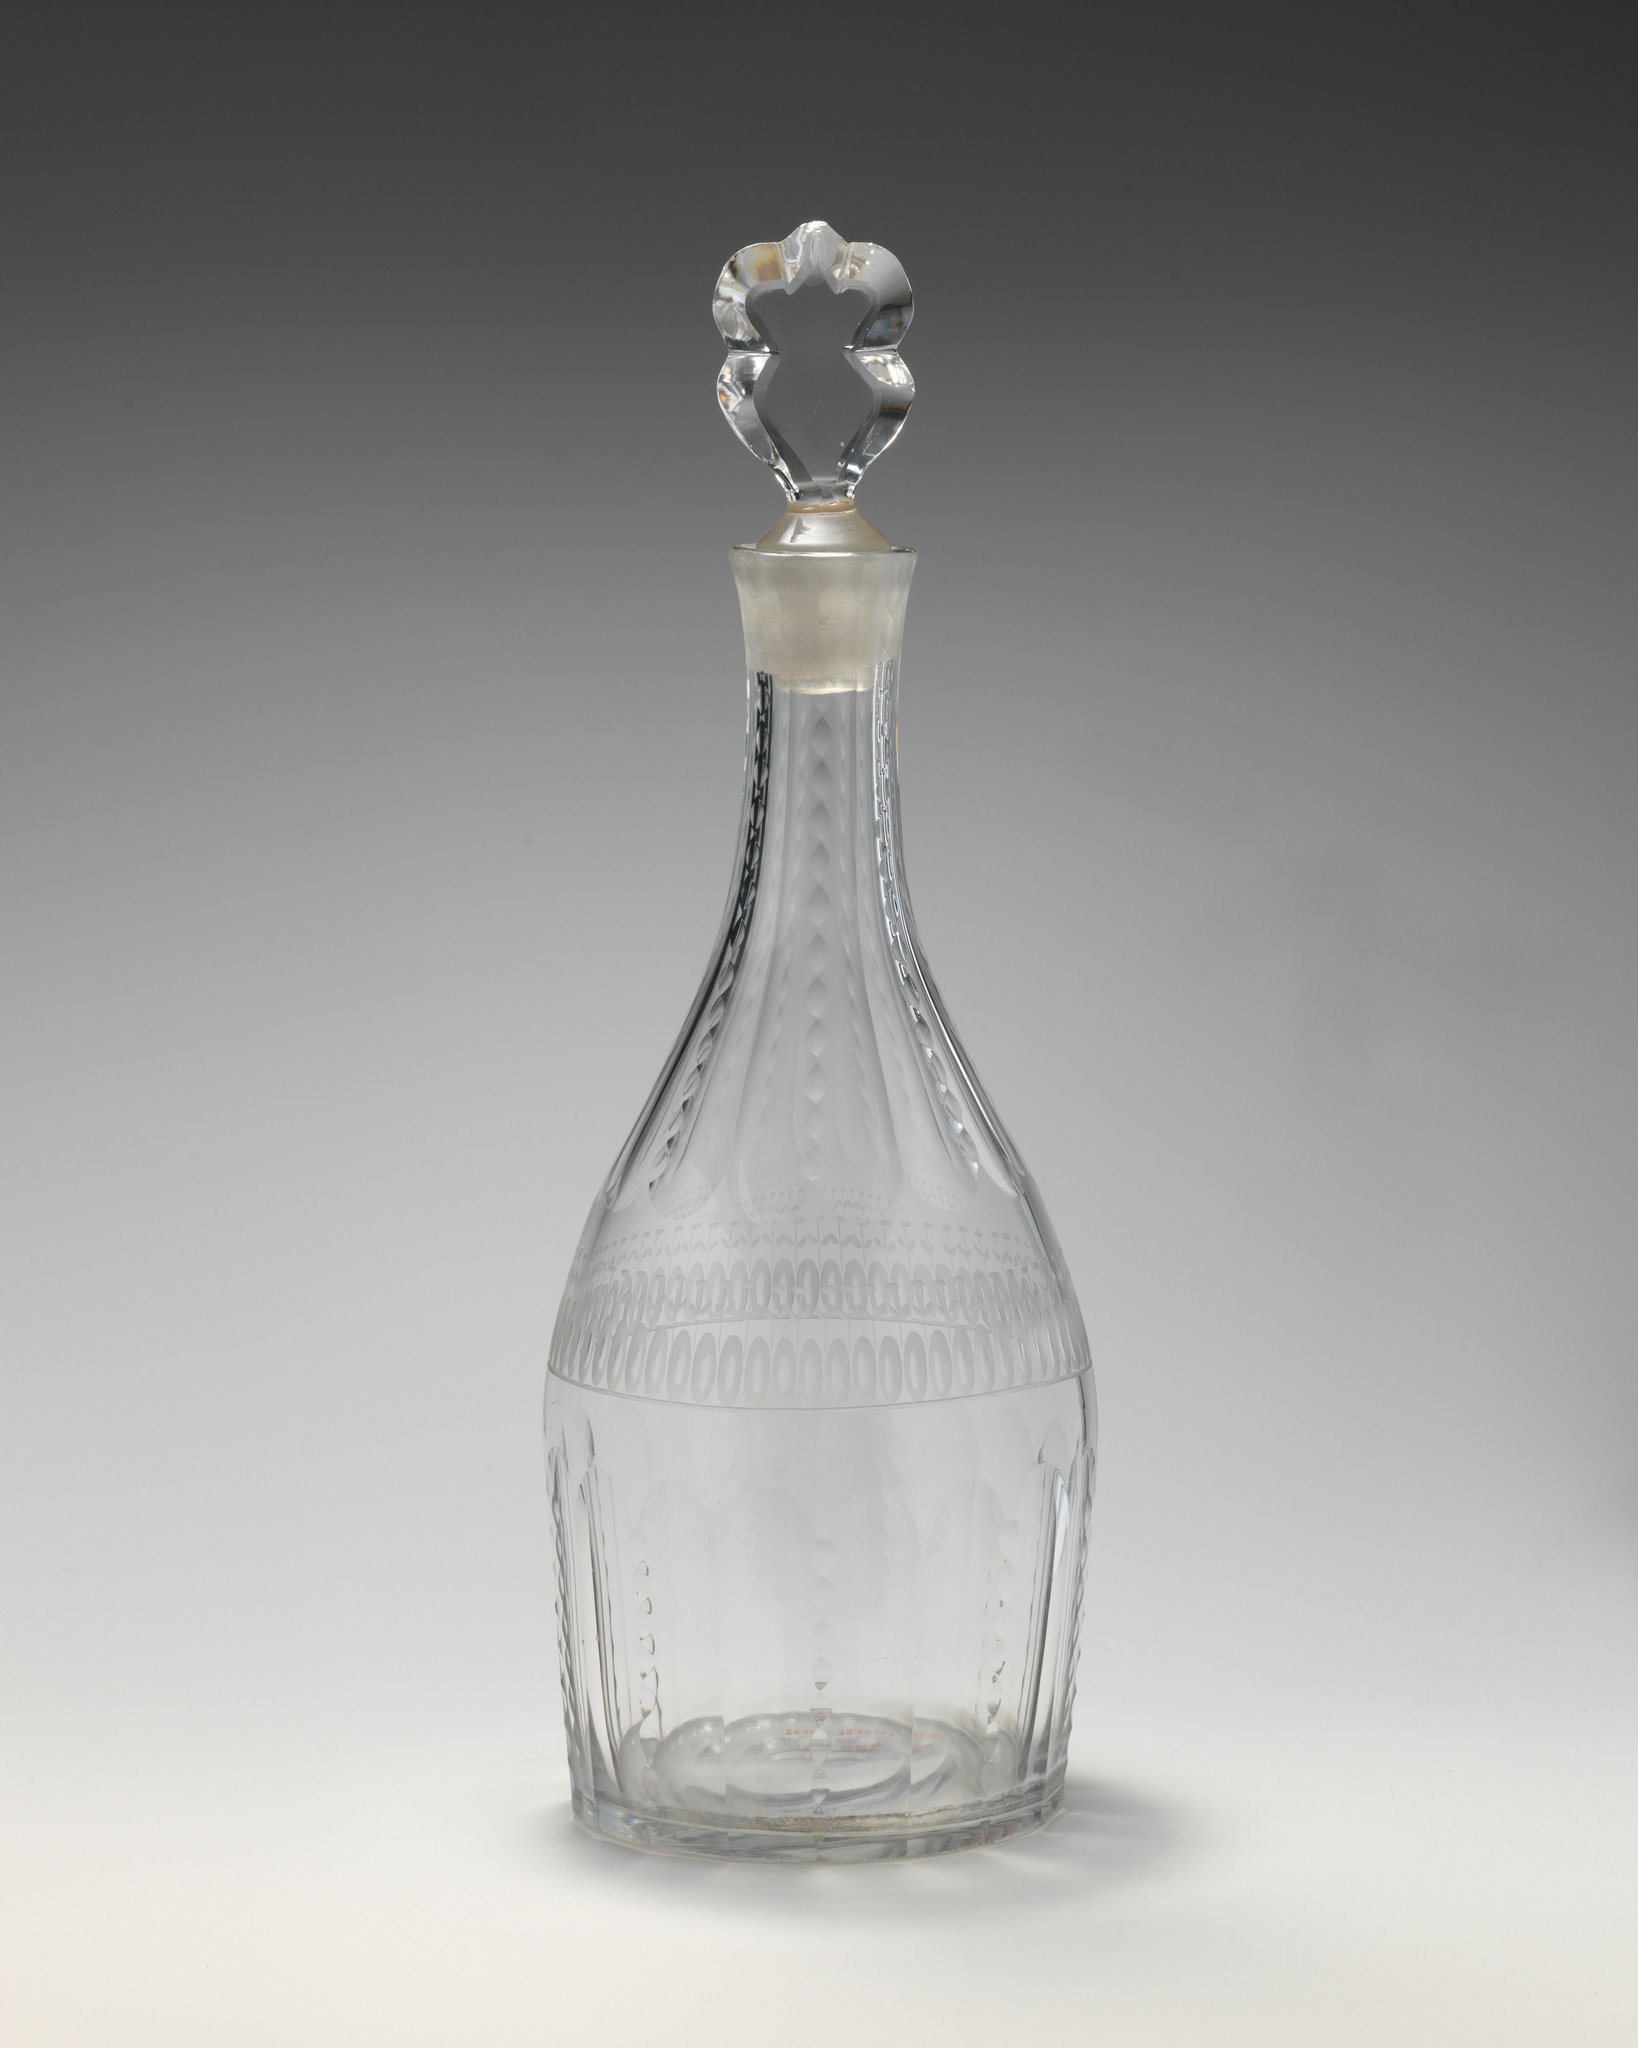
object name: decanter with stopper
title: Decanter with stopper (one of a pair)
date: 1767-1800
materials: glass